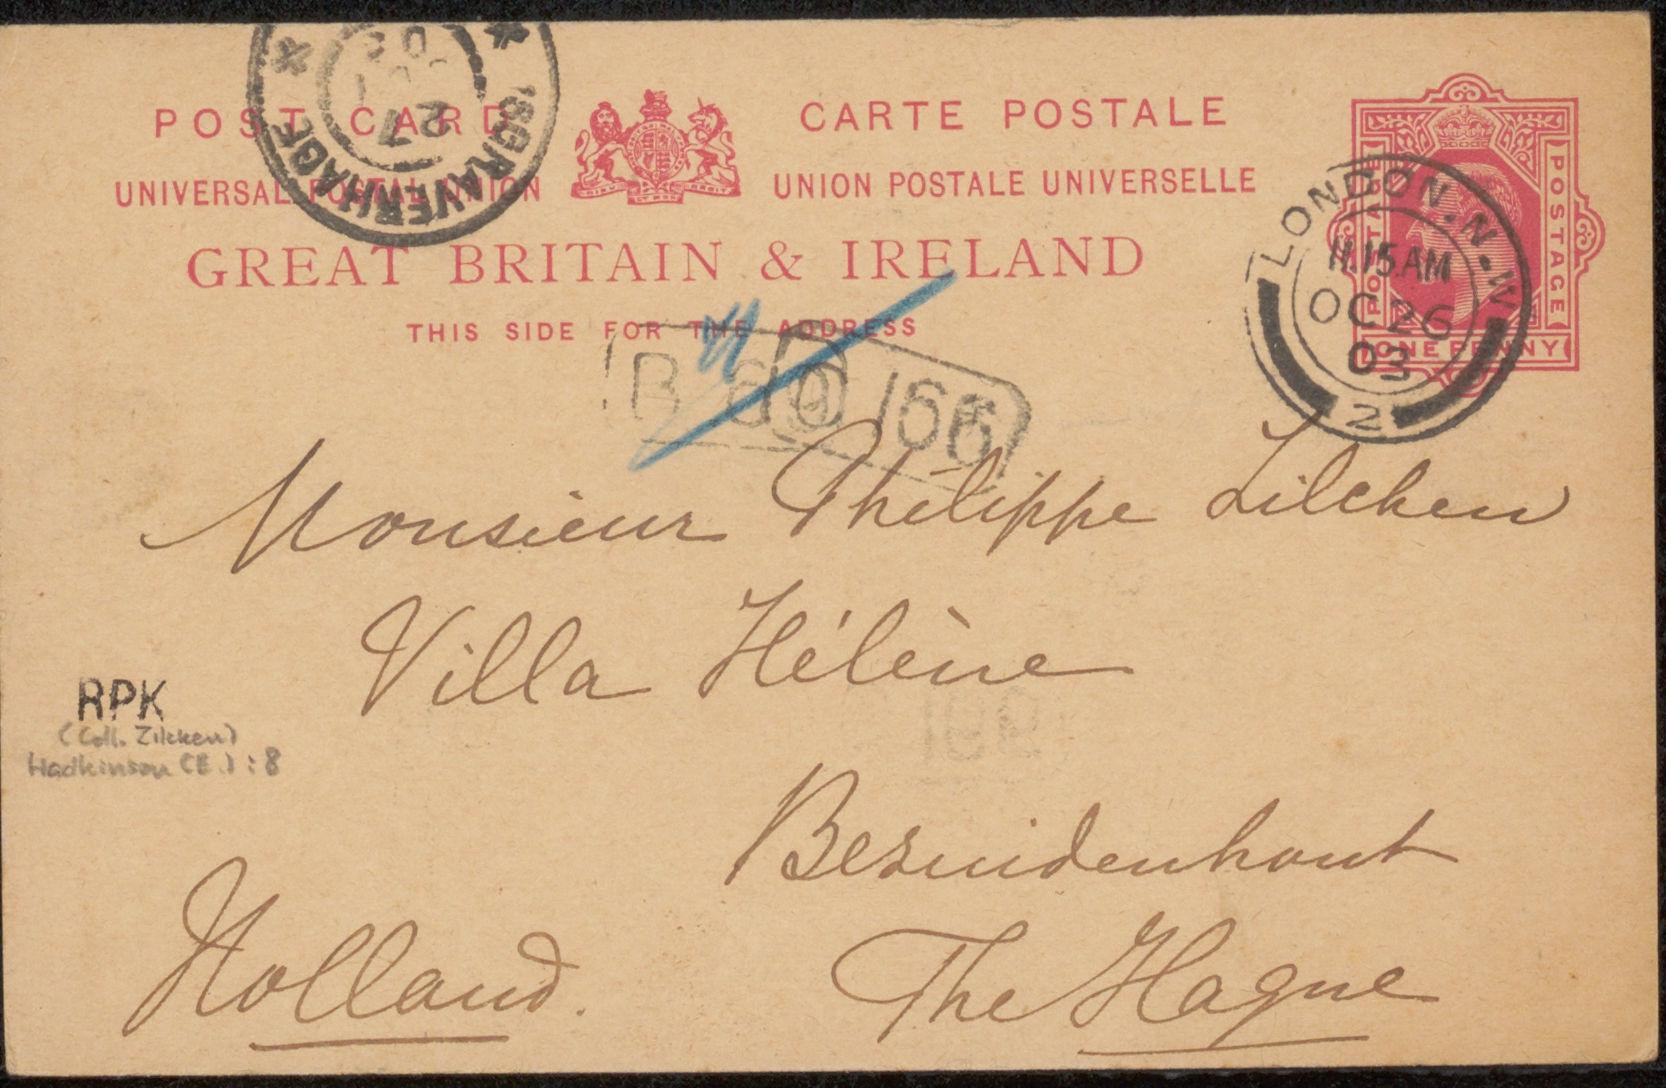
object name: postcard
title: Briefkaart aan Philip Zilcken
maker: ernestine hadkinson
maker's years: 1863-1928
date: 1903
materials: cardboard, ink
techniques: pen, writing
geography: hampstead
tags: the hague, painter, philip zilcken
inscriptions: collector's mark: ‘RPK’